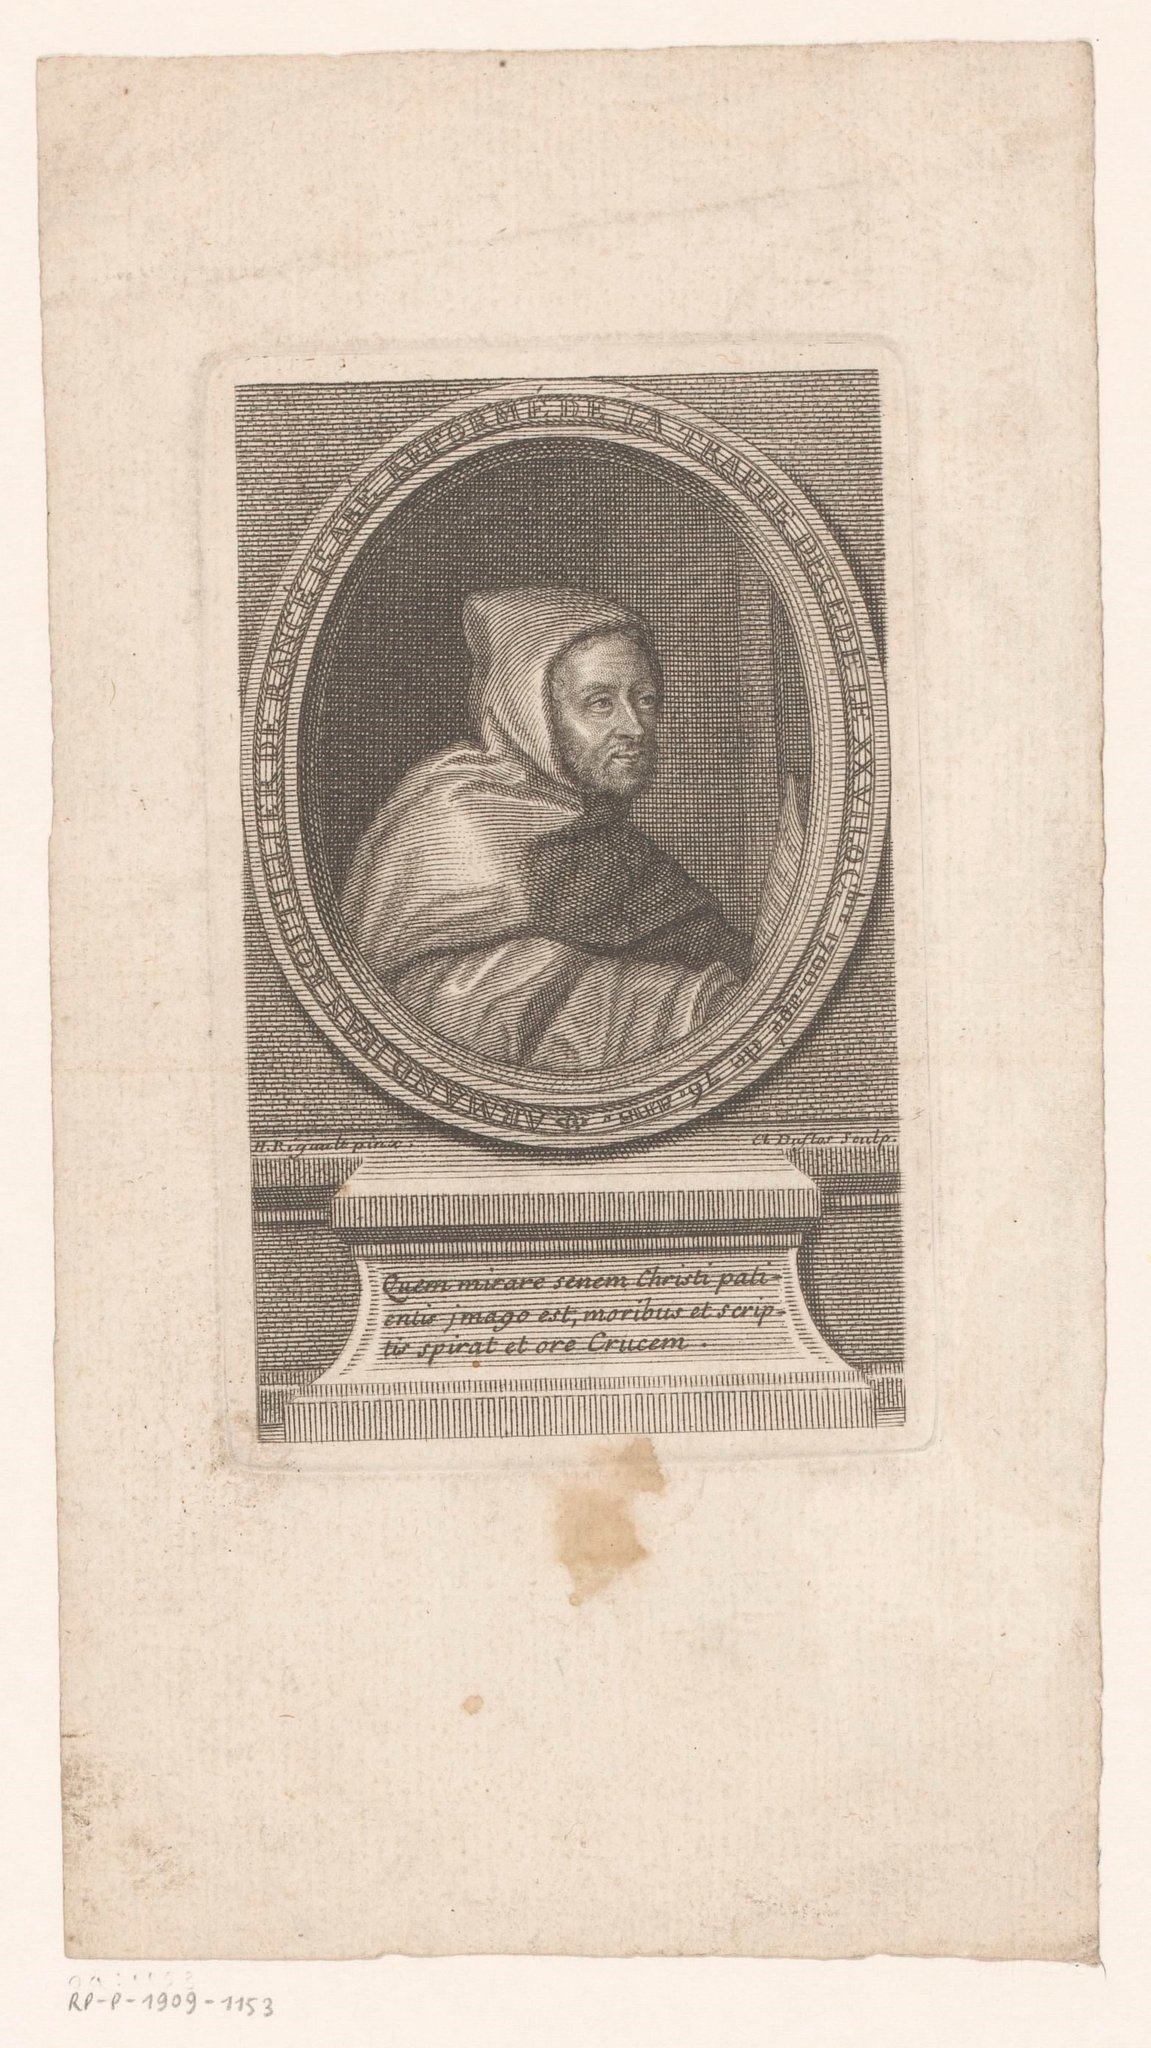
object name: print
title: Portret van Armand Jean Le Bouthillier de Rancé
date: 1675-1727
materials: paper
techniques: engraving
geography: france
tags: paris, priest, ornament ~ medallion, historical persons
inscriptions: collector's mark: Lugt 2228